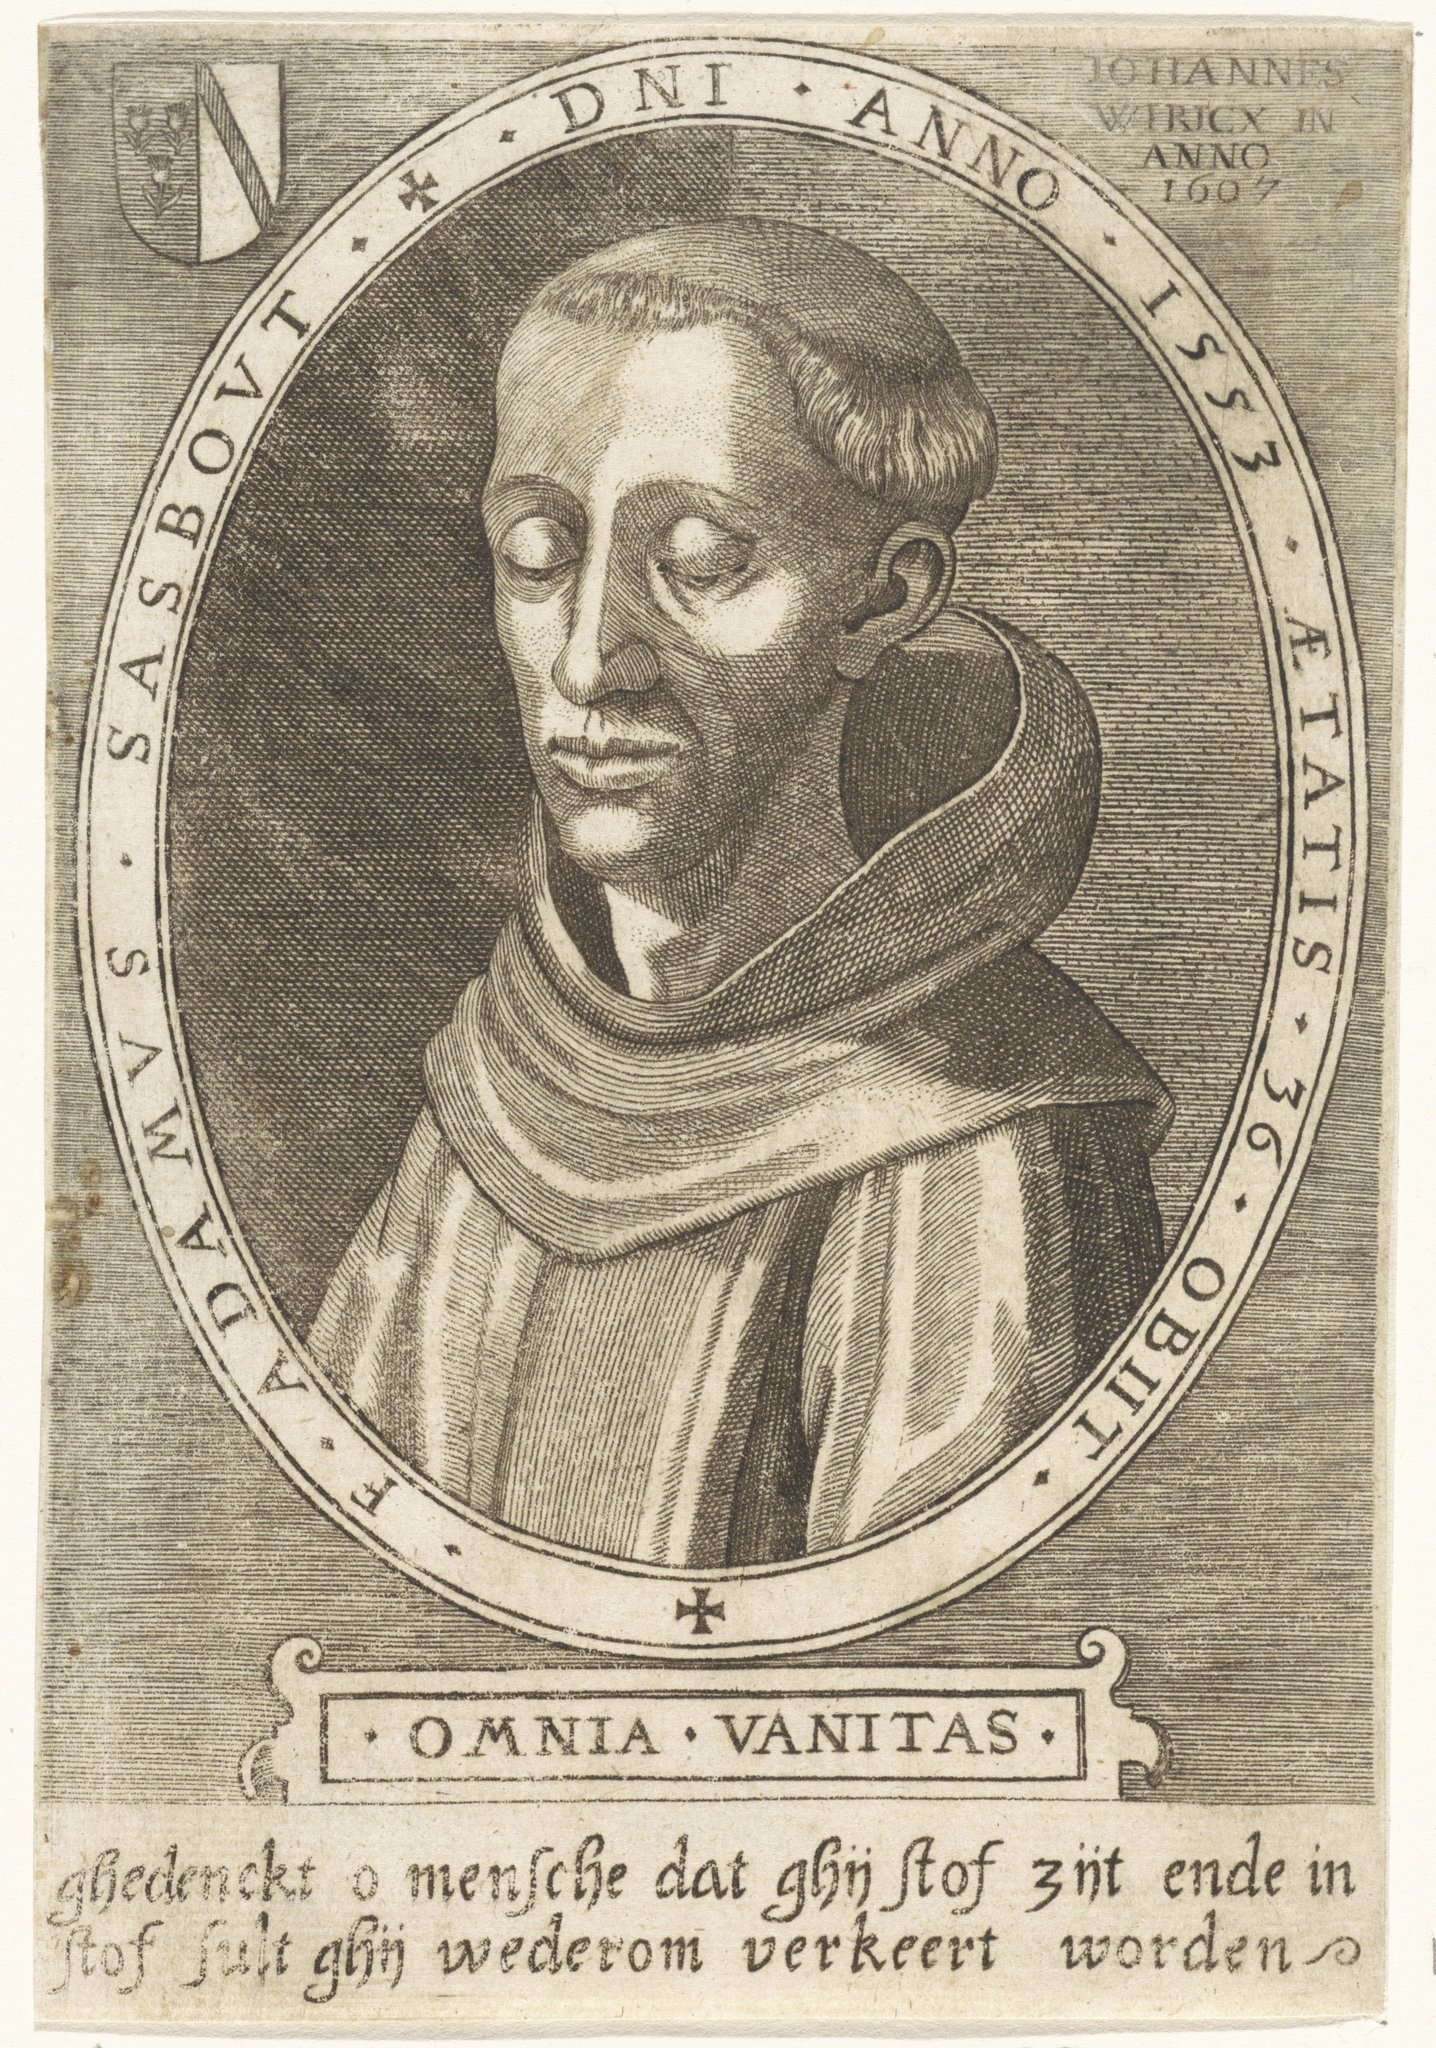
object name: print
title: Omnia Vanitas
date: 1607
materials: paper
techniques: engraving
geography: antwerp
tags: louvain, monk(s), friar(s), eyes closed, armorial bearing, heraldry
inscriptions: collector's mark: Lugt 2228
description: Prent gebruikt in: Bukentop, Henricus de. Dictionarium in quo voces omnes difficilioris significationis: quæ in Vulgata nostra S. Scripturæ. Leuven: Henricus van Overbeeck, 1696.